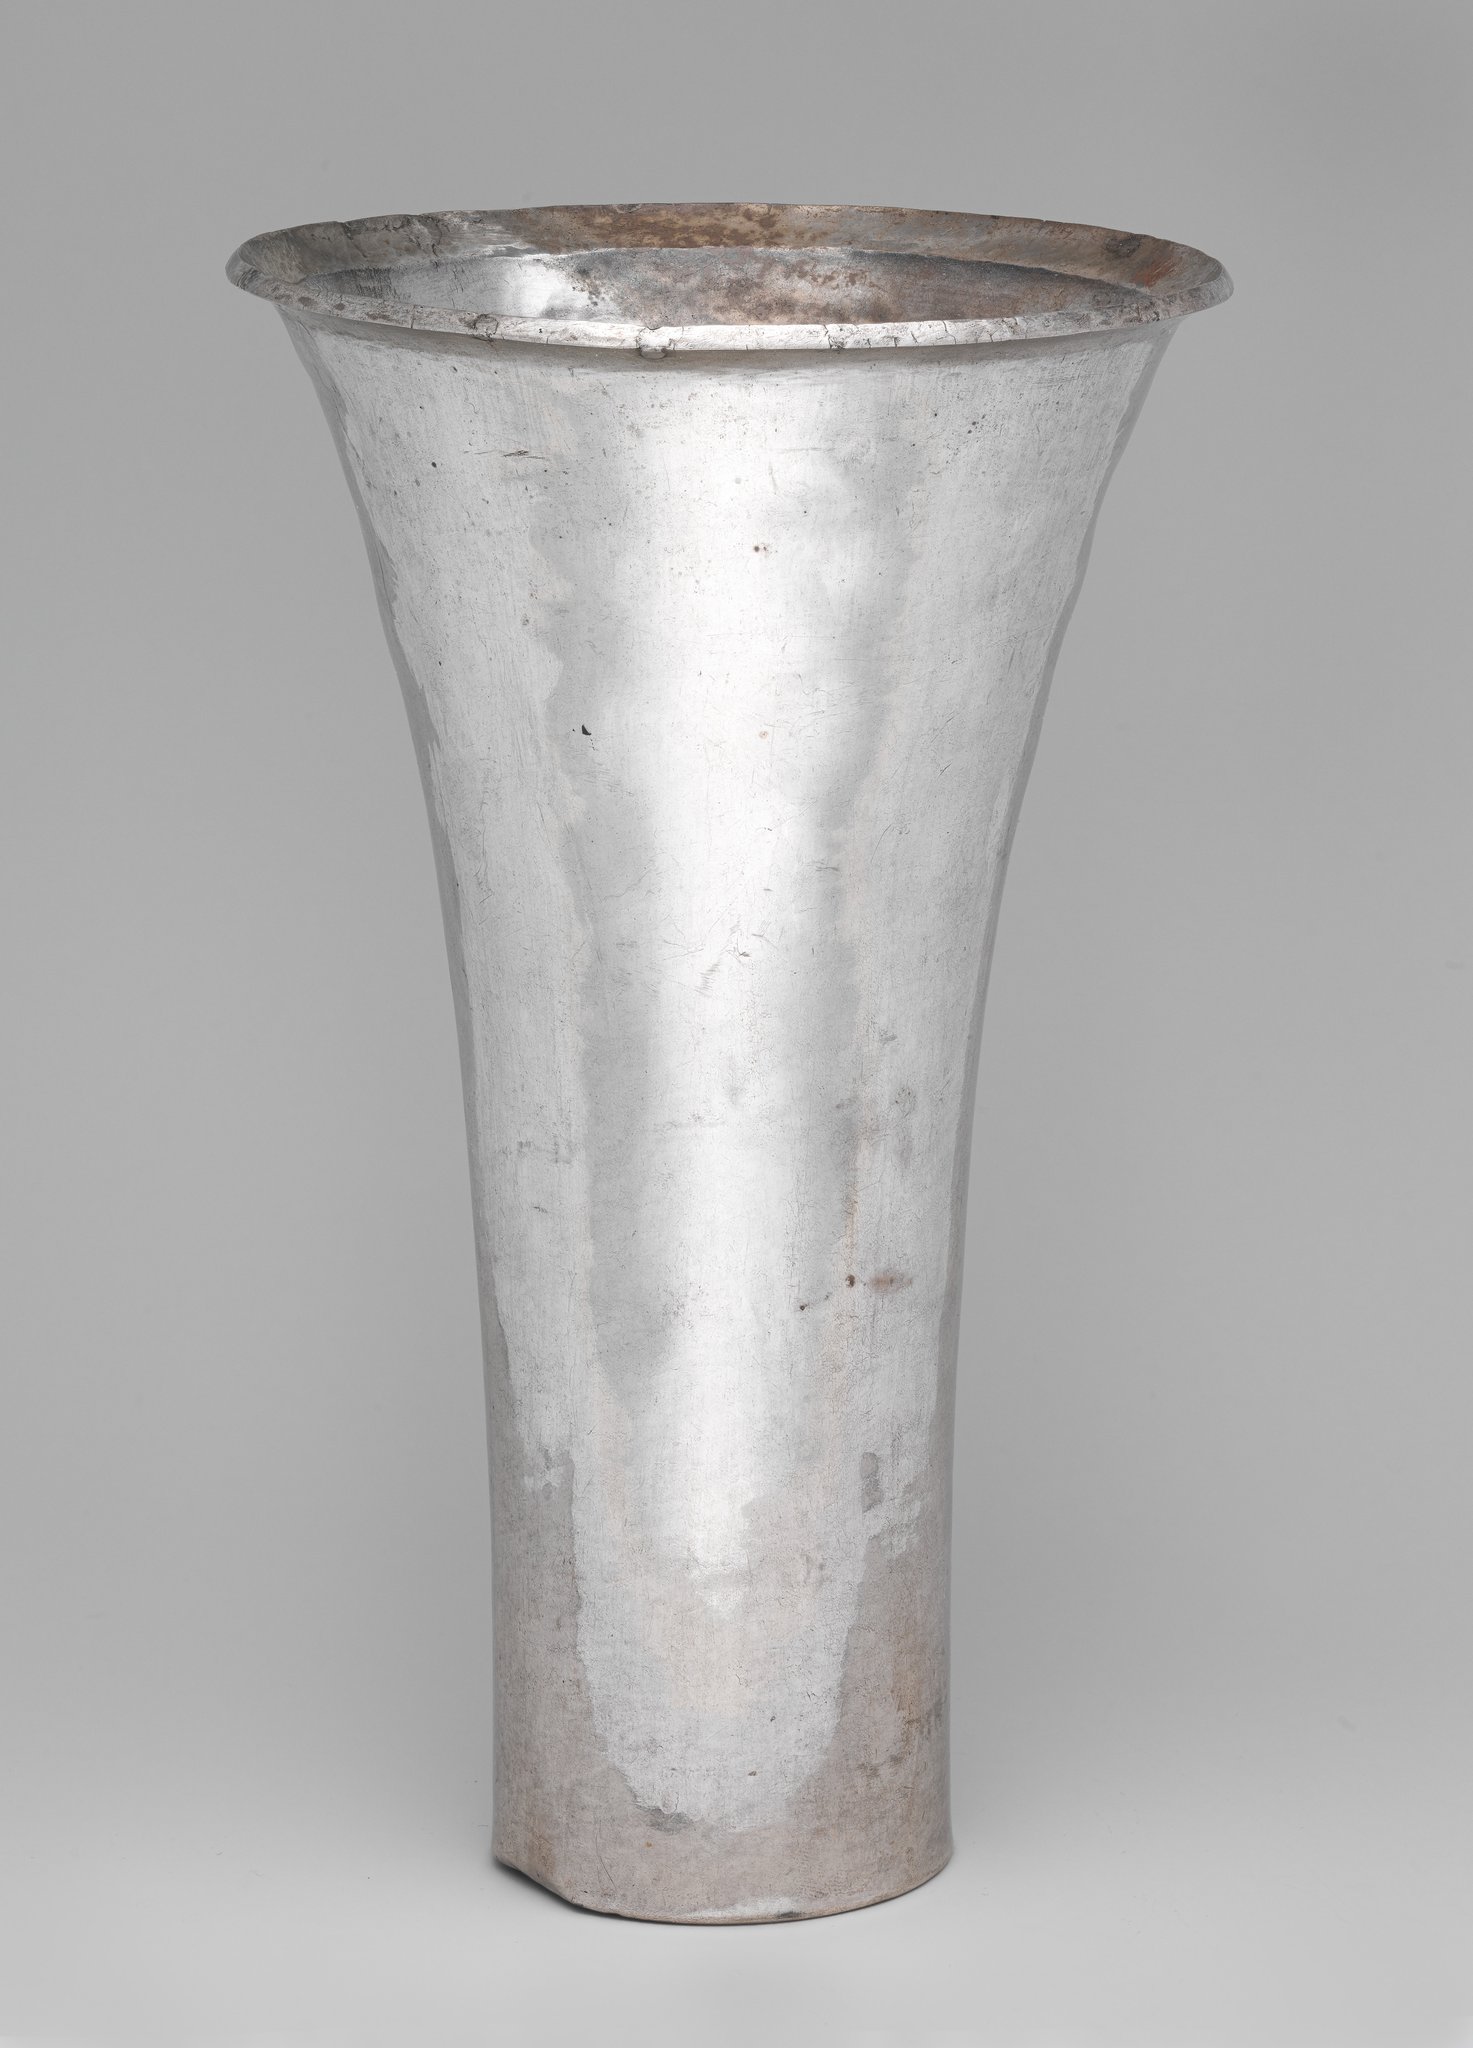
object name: beaker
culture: chimú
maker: chimú artist(s)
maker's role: artist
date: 1300-1470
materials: silver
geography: peru